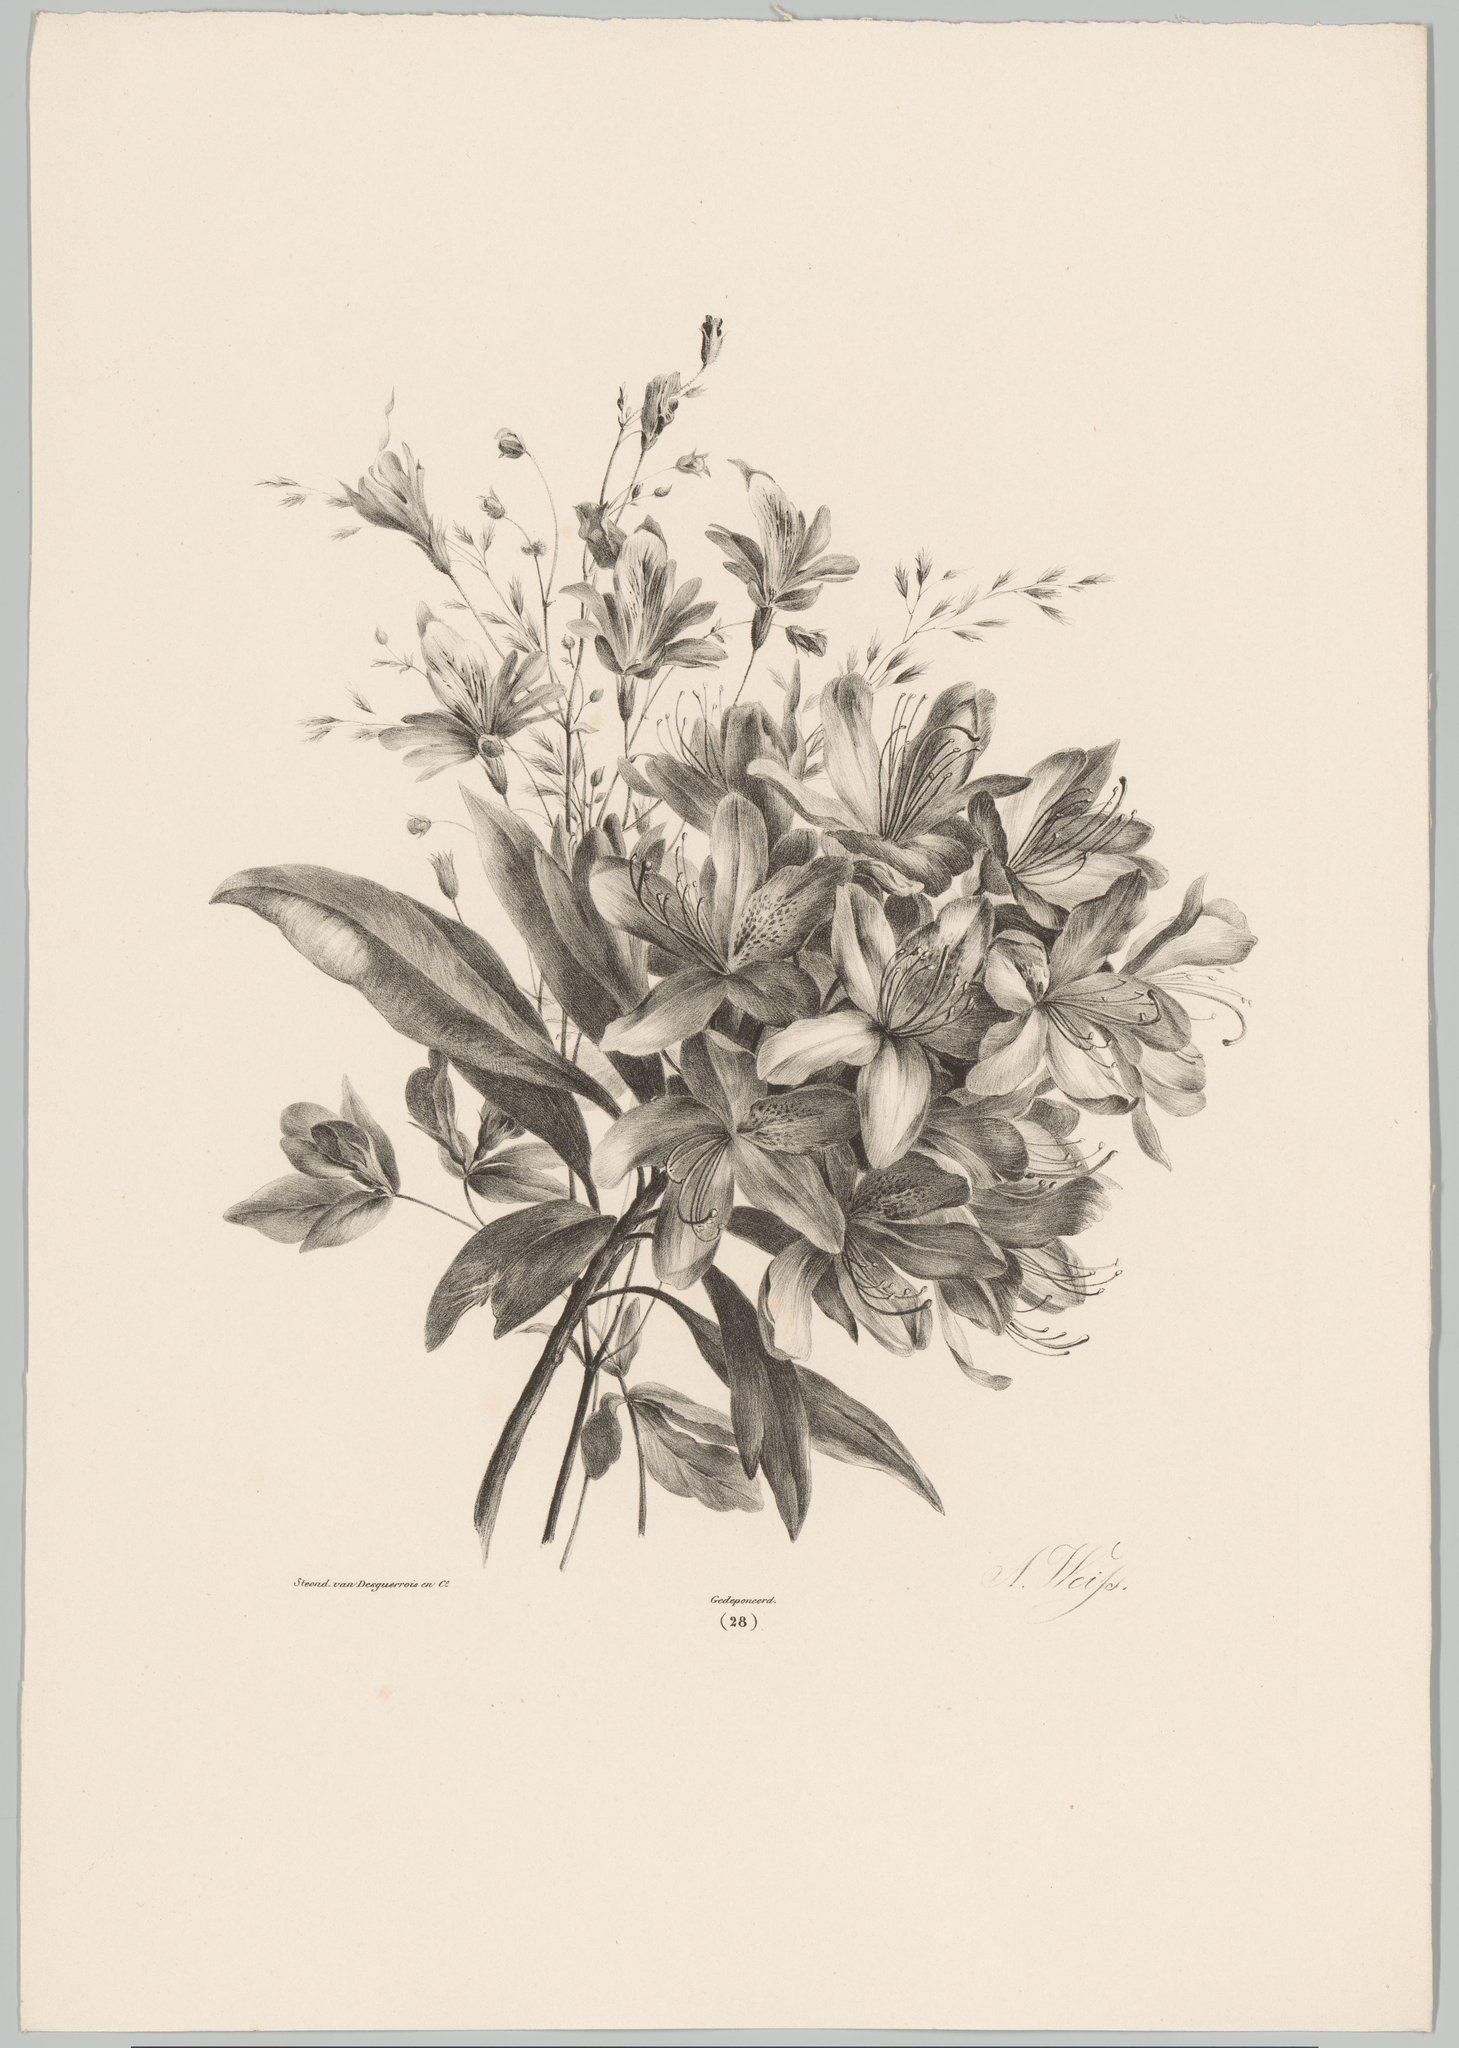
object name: print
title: Lelies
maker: anton weiss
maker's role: draughtsman, print maker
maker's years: 1801-1851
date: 1836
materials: paper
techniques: lithograph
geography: amsterdam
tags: flowers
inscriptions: : ‘Gedeponeerd.’, collector's mark: Lugt 2228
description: Onderdeel van een omslag met een serie van eenenveertig lithografieën van bloemen en fruit.